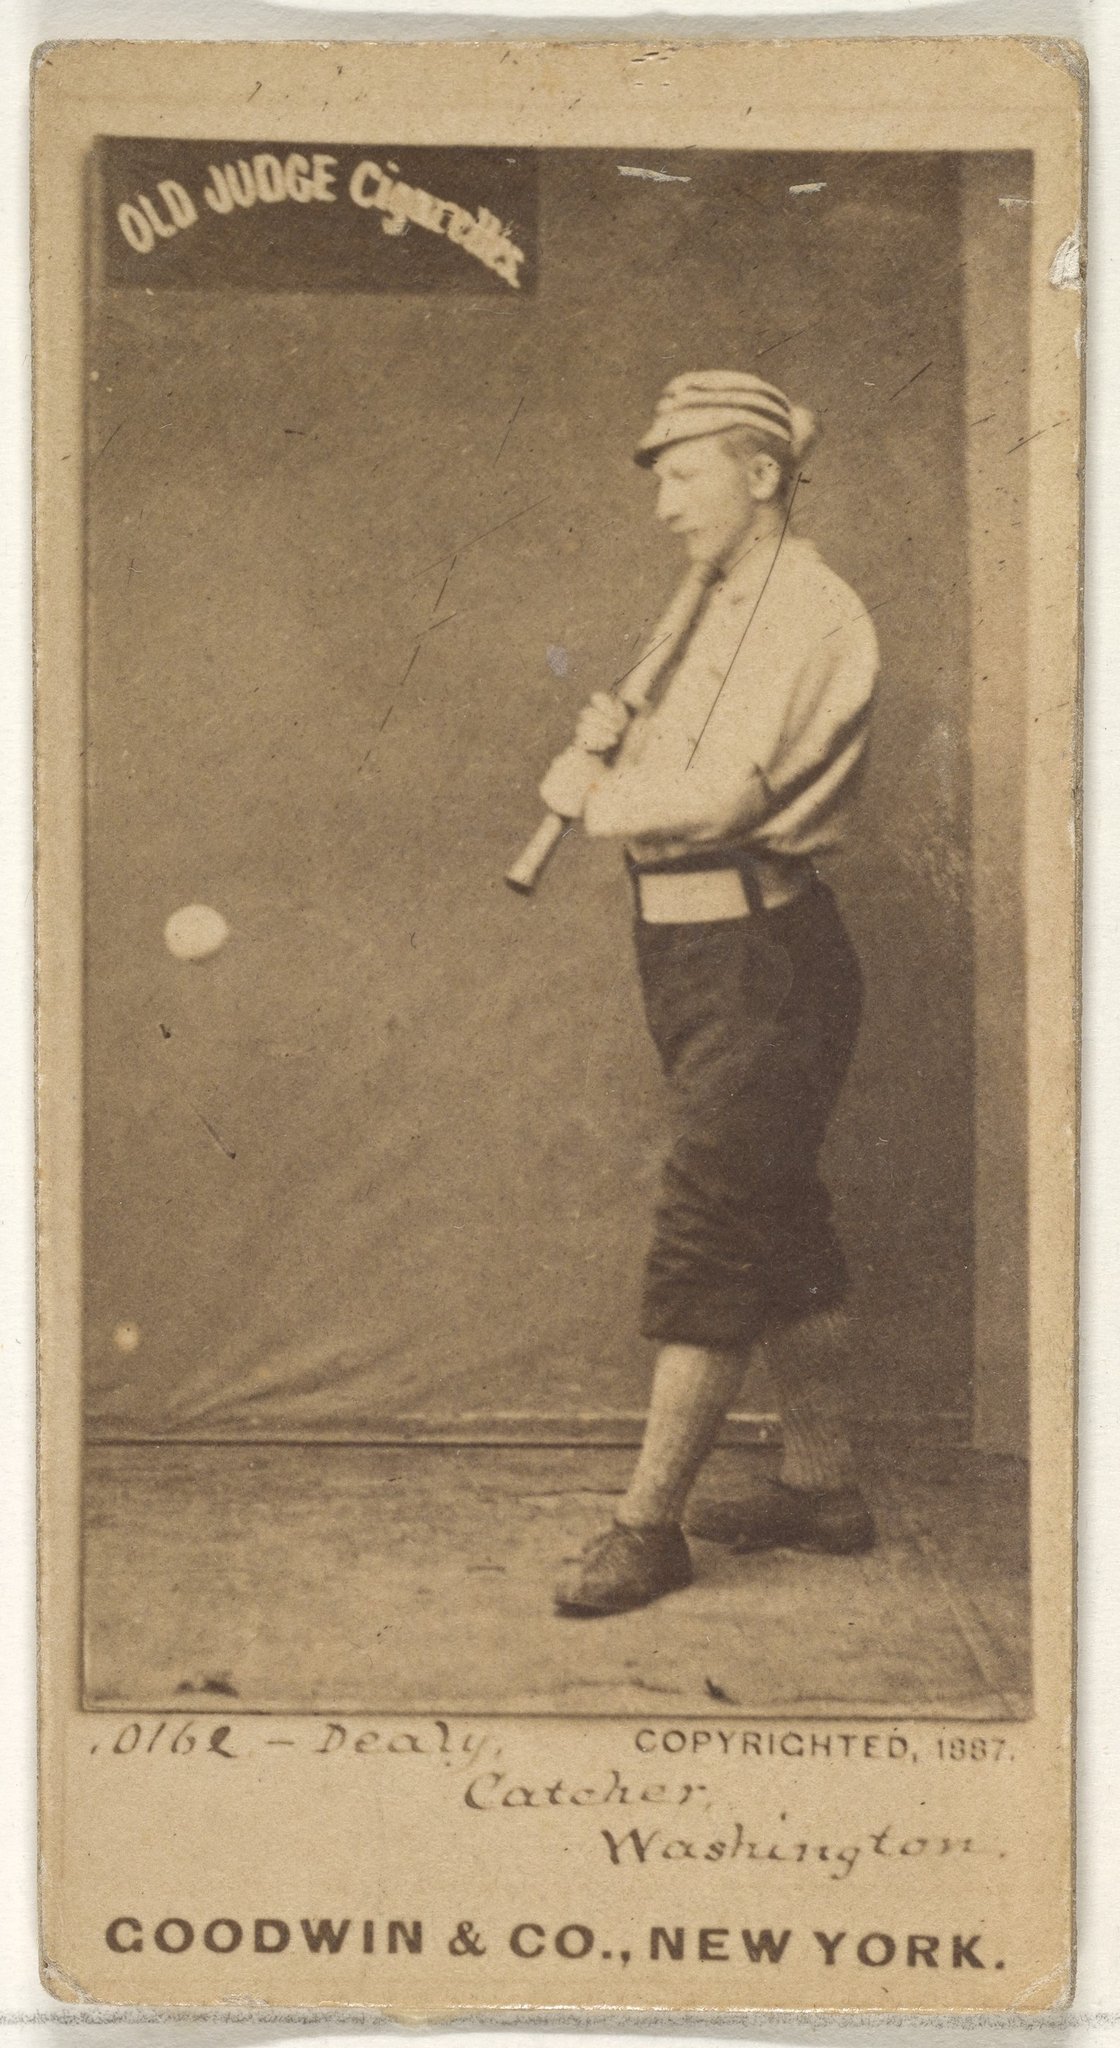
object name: baseball card, photograph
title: Patrick "Pat" E. Dealy, Catcher, Washington Nationals, from the Old Judge series (N172) for Old Judge Cigarettes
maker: goodwin & company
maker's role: publisher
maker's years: 1850-1950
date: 1887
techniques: albumen silver print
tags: men,portraits,baseball,athletes